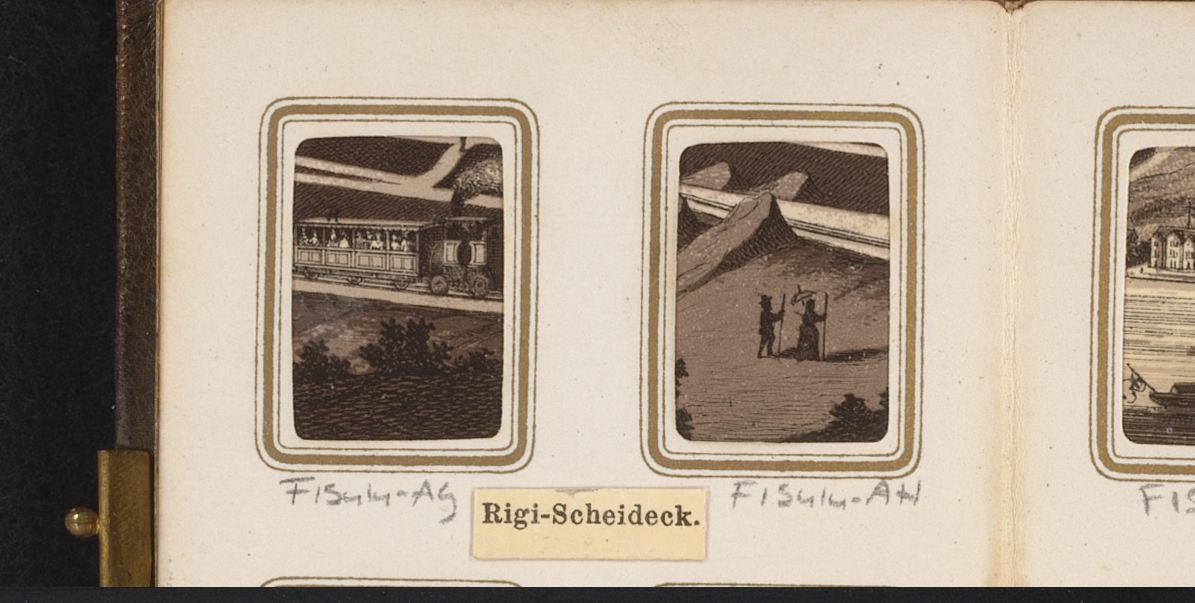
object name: album leaf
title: Trein in Rigi Scheidegg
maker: Anonymous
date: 1851-1910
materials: paper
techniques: lithograph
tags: passenger train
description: Deze prent maakt deel uit van een album.